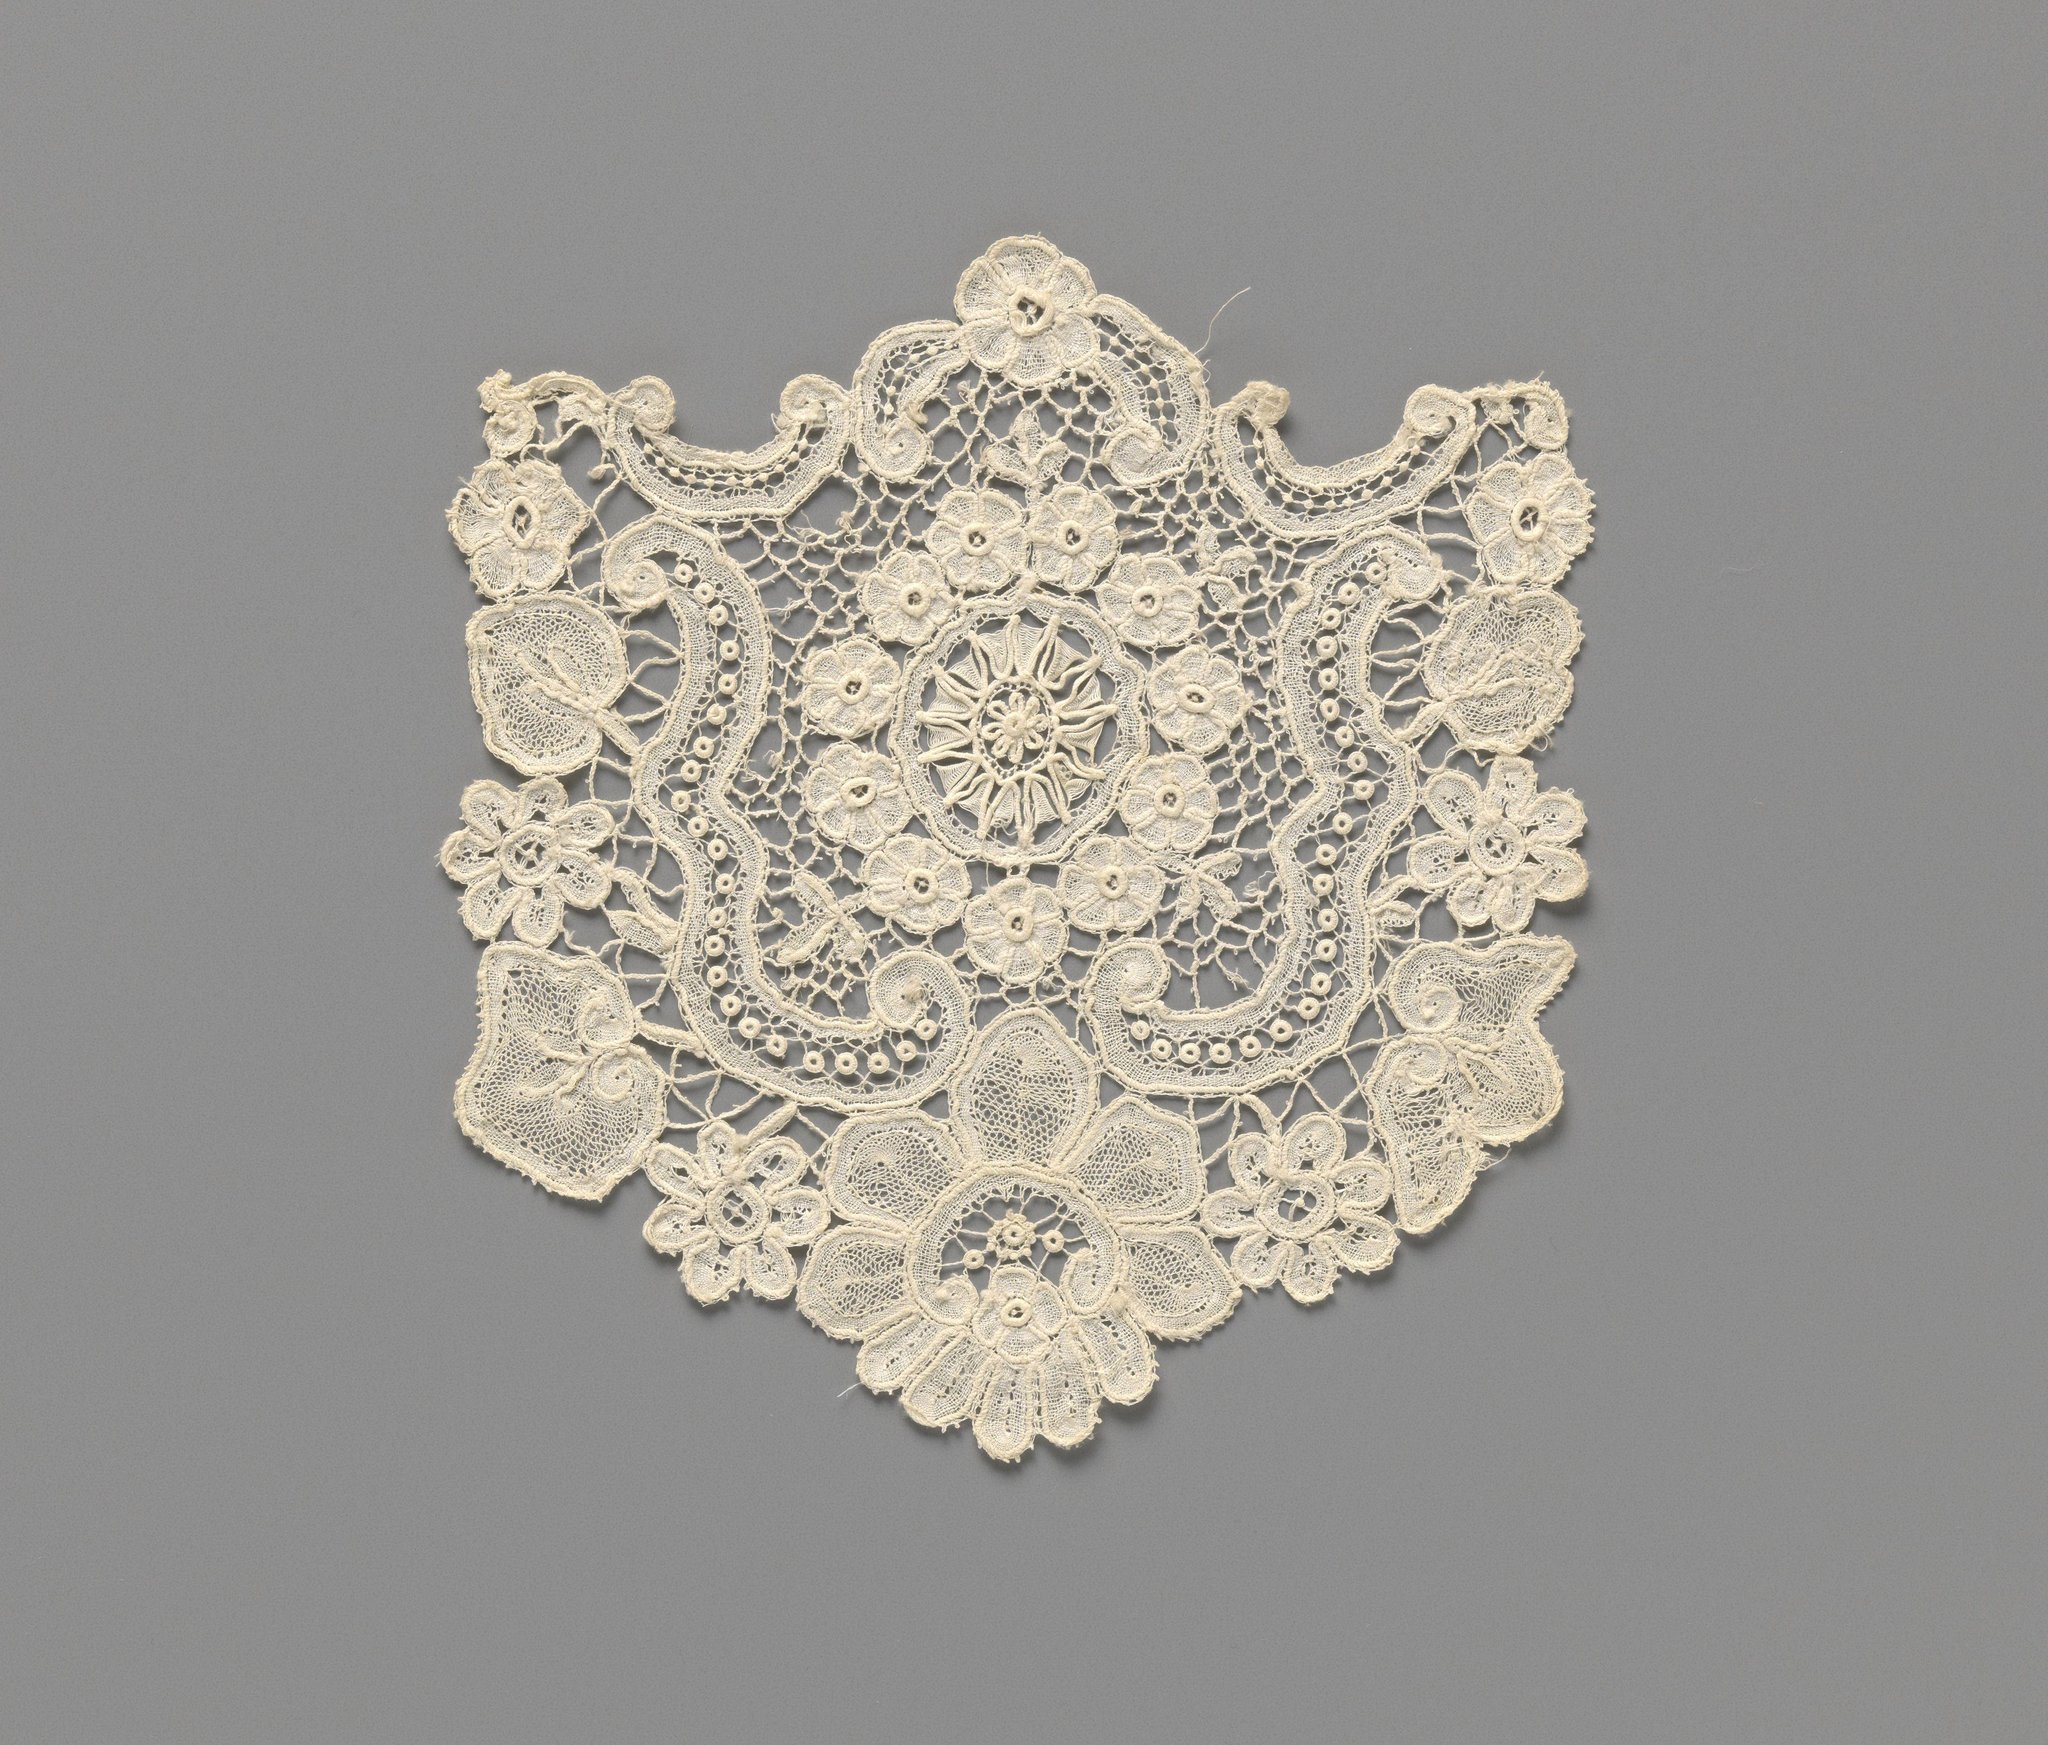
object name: womenswear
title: Slip van een das van gemengde kant in wapenschildvorm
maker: Anonymous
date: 1900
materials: linen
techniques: lace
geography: brussels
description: Slip van een das van naturelkleurige gemengde kant - kloskant in combinatie met naaldkant - Brusselse duchesse-kant. Wapenschild-vormig model. Symmetrisch patroon met in het midden een ovaal medaillon met daarin een bloempje in naaldkant met 'zonnestralen' er omheen. Om dit centrale motief staat een ovale lijst van aaneengeschakelde gekloste rozetbloempjes met bloemhartjes van naaldkant. Het medaillon is met een relatief grove vlechtengrond verbonden met een wapenschild-vormige omlijsting van gekloste c-voluten en omkrullend bandwerk met daarin een siergrond van naaldkant (stipjes in de c-voluten en ringetjes in het overige bandwerk). Deze omlijsting is op haar beurt weer met een zigzag van vlechtjes verbonden aan verschillende soorten bloemen, die tevens de schulpenrand vormen. De bloemen nemen van boven naar beneden in grote toe. Deze bloemen zijn grotendeels gemaakt in netslag, met randjes in linnenslag. Ale motieven zijn voorzien van dikke contourdraden.